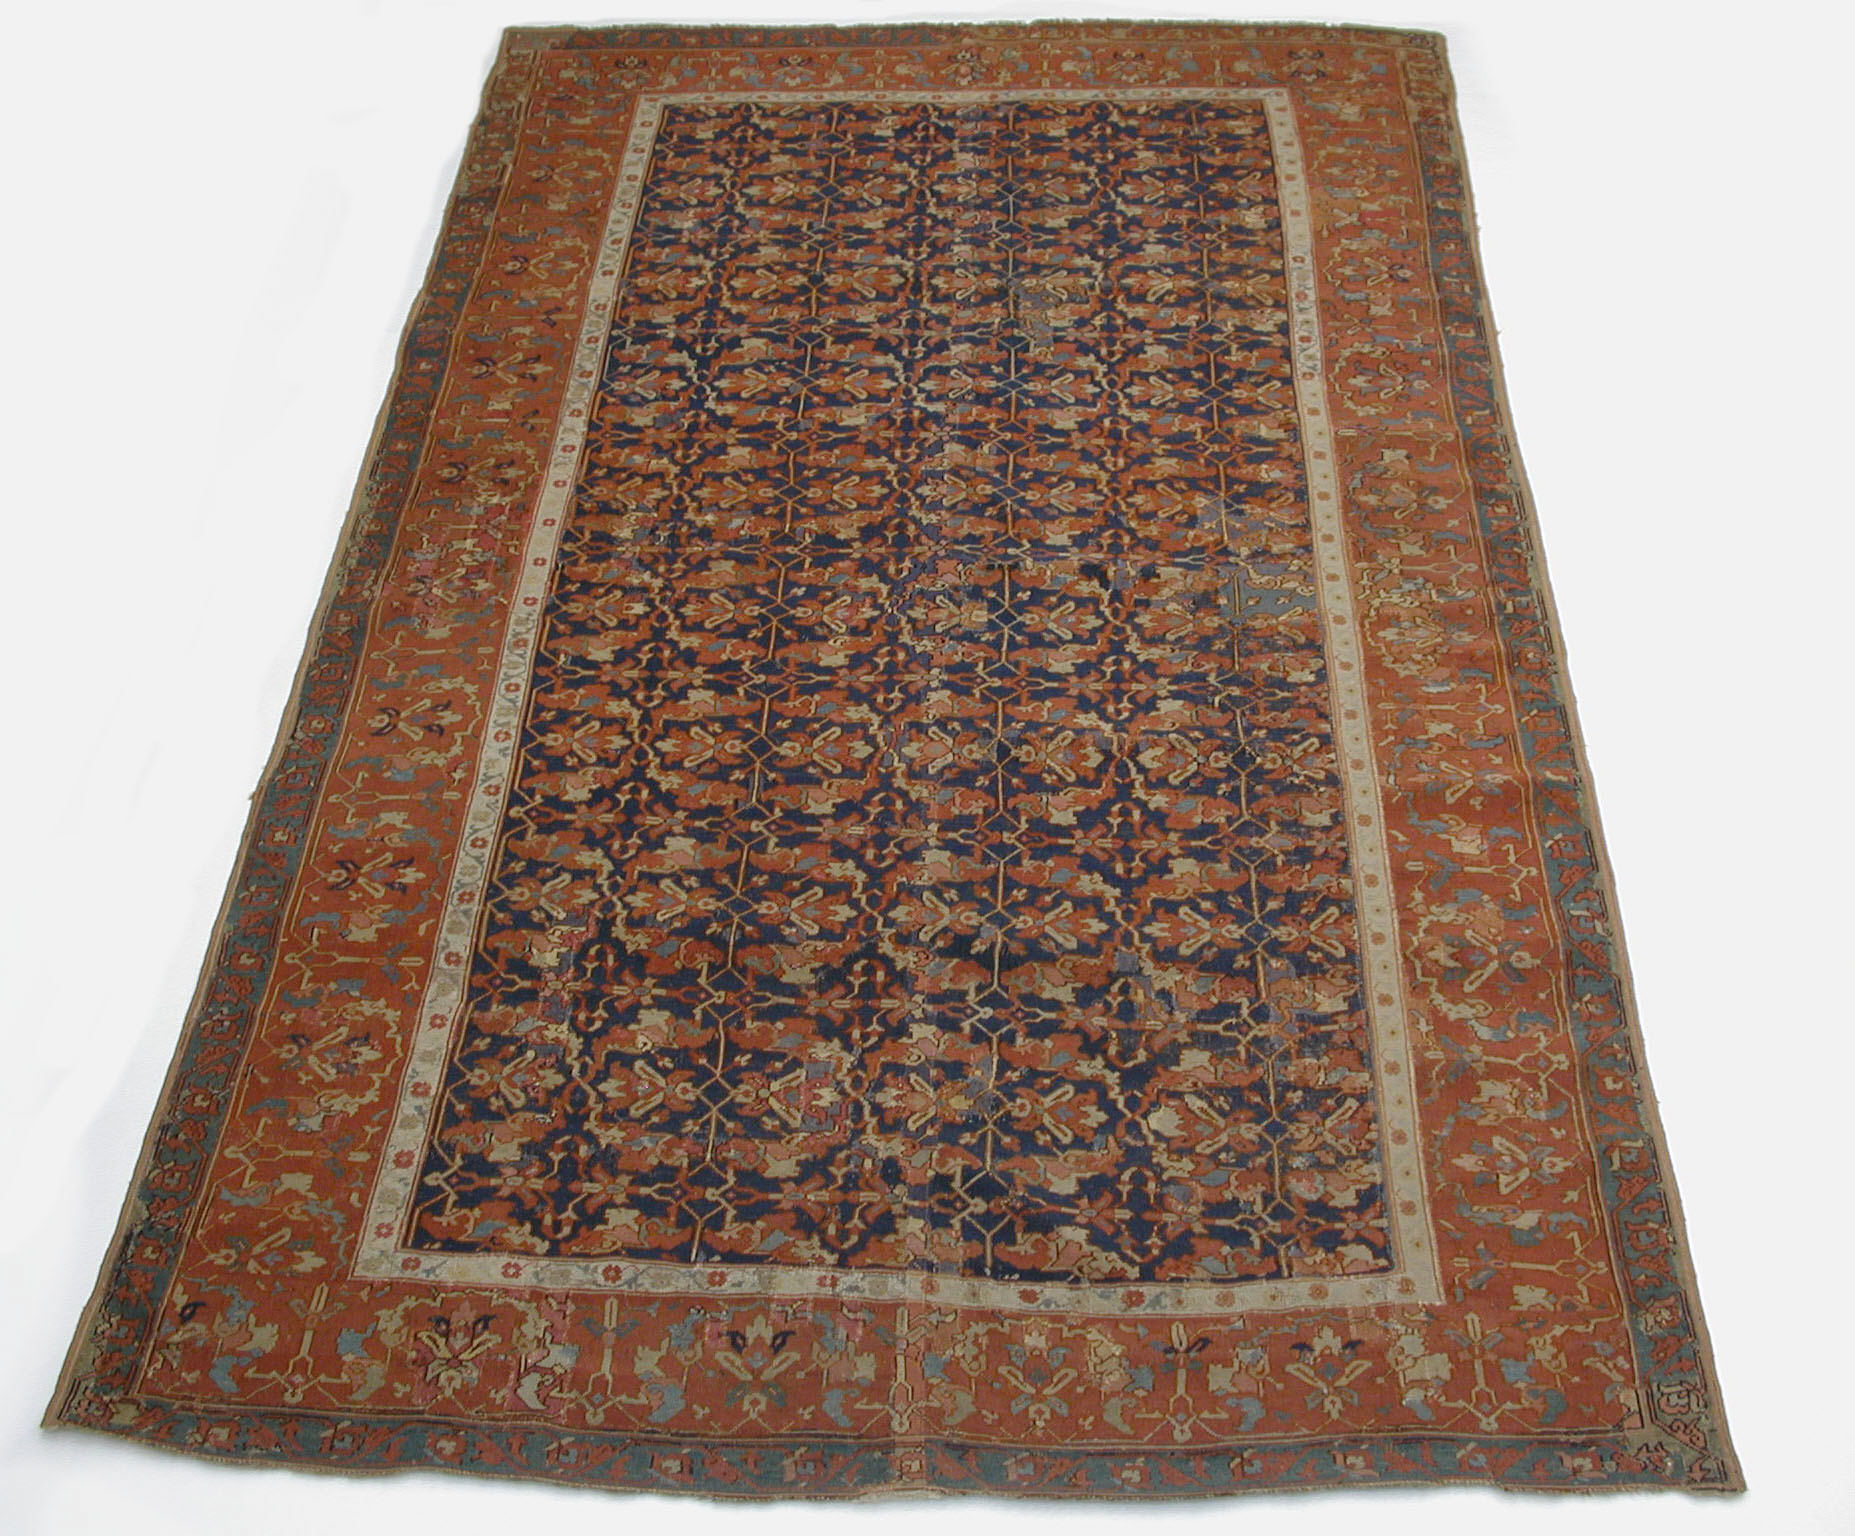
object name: carpet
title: Lotus-Patterned Ushak Carpet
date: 1501-1550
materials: wool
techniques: pile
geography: turkey